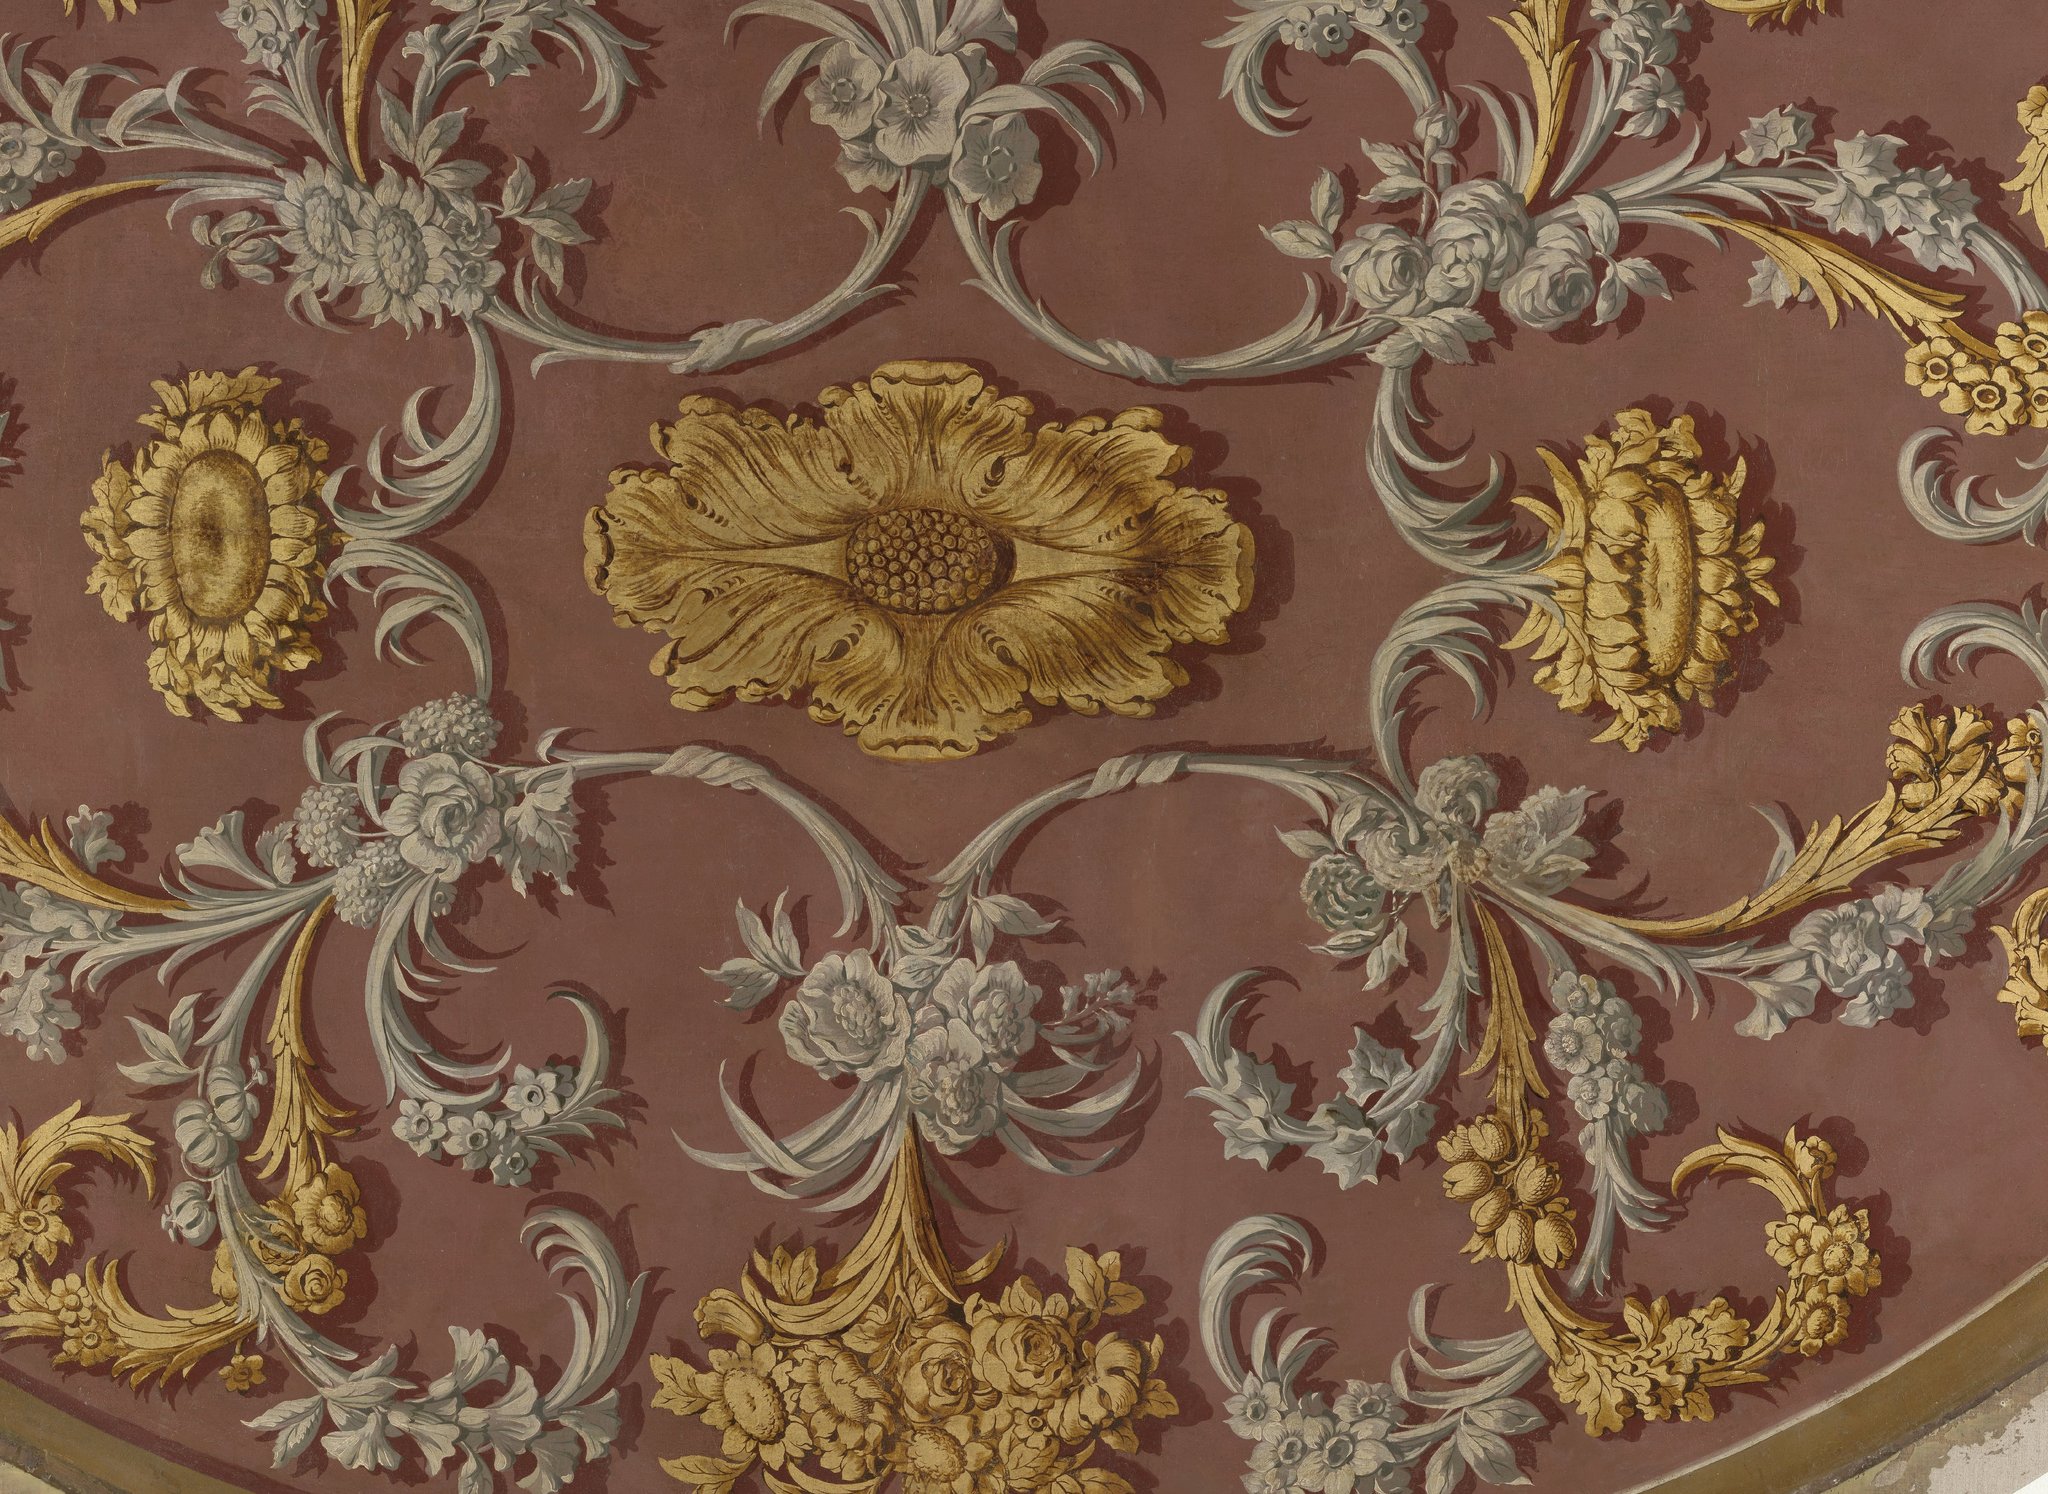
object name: ceiling painting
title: Lacquer room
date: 1695-1755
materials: canvas, oil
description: This room was made for the Court of the Stadholders at Leeuwarden. It formed part of the apartment of the consort of the Frisian stadholder, Princess Albertine Agnes of Orange and Nassau. The walls are mounted with Chinese screens of Coromandel lacquer. In this enchanting room, filled with exotic furniture and porcelain, the princess liked to drink tea from China.